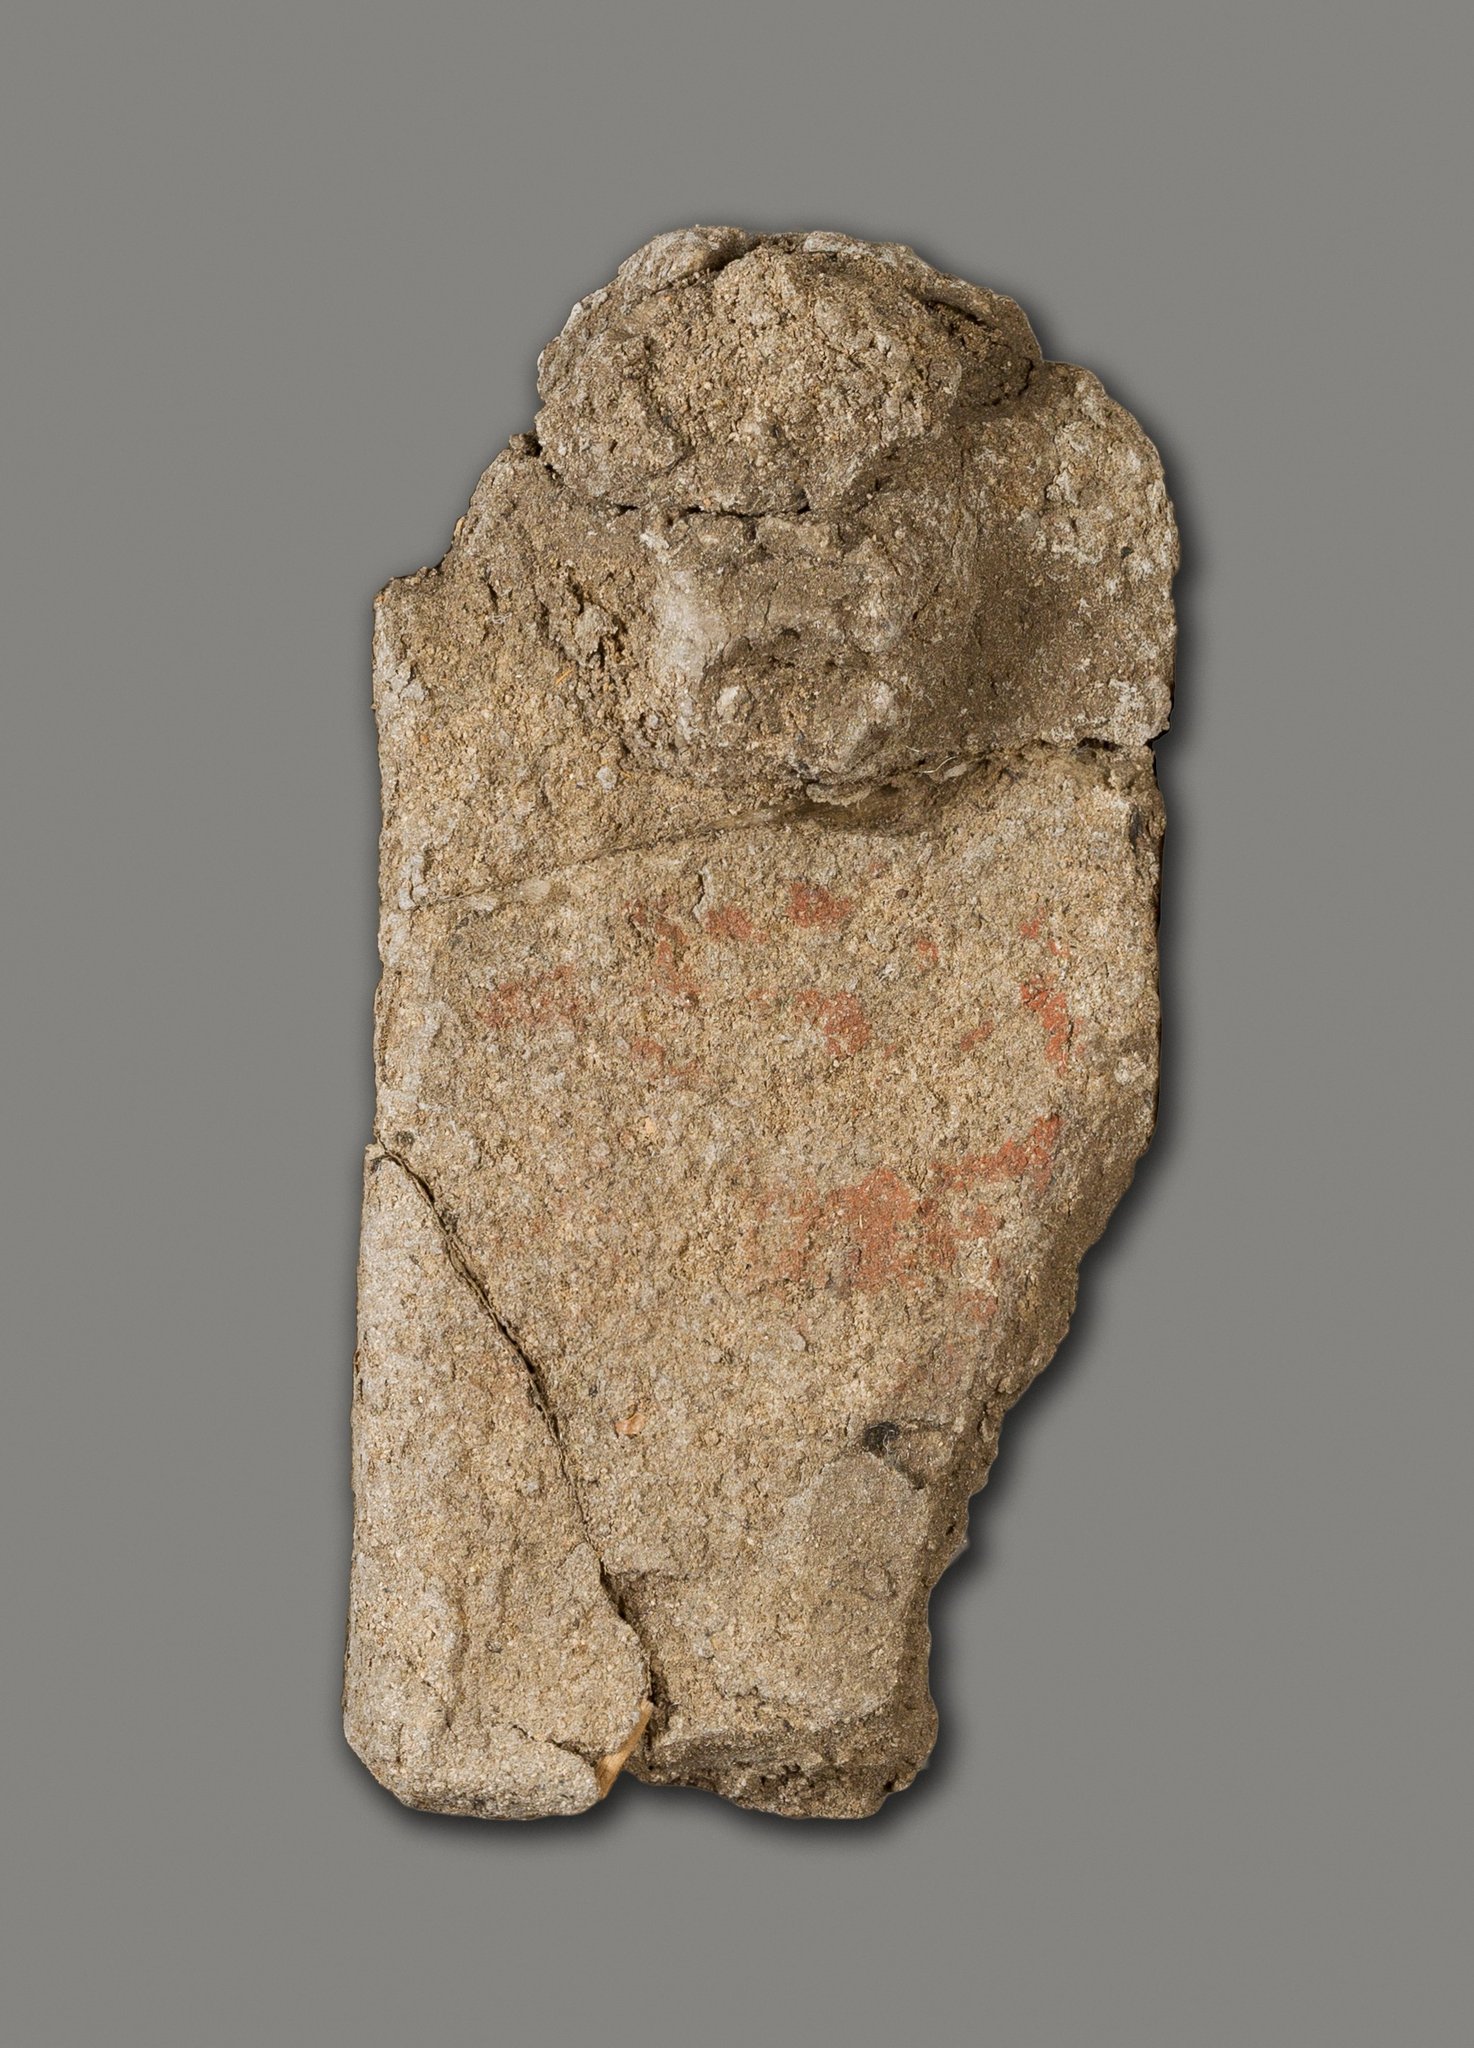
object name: figure, magical, execration, tablet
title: Magical Figure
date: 1802-1550 BCE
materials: clay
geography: egypt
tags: faces